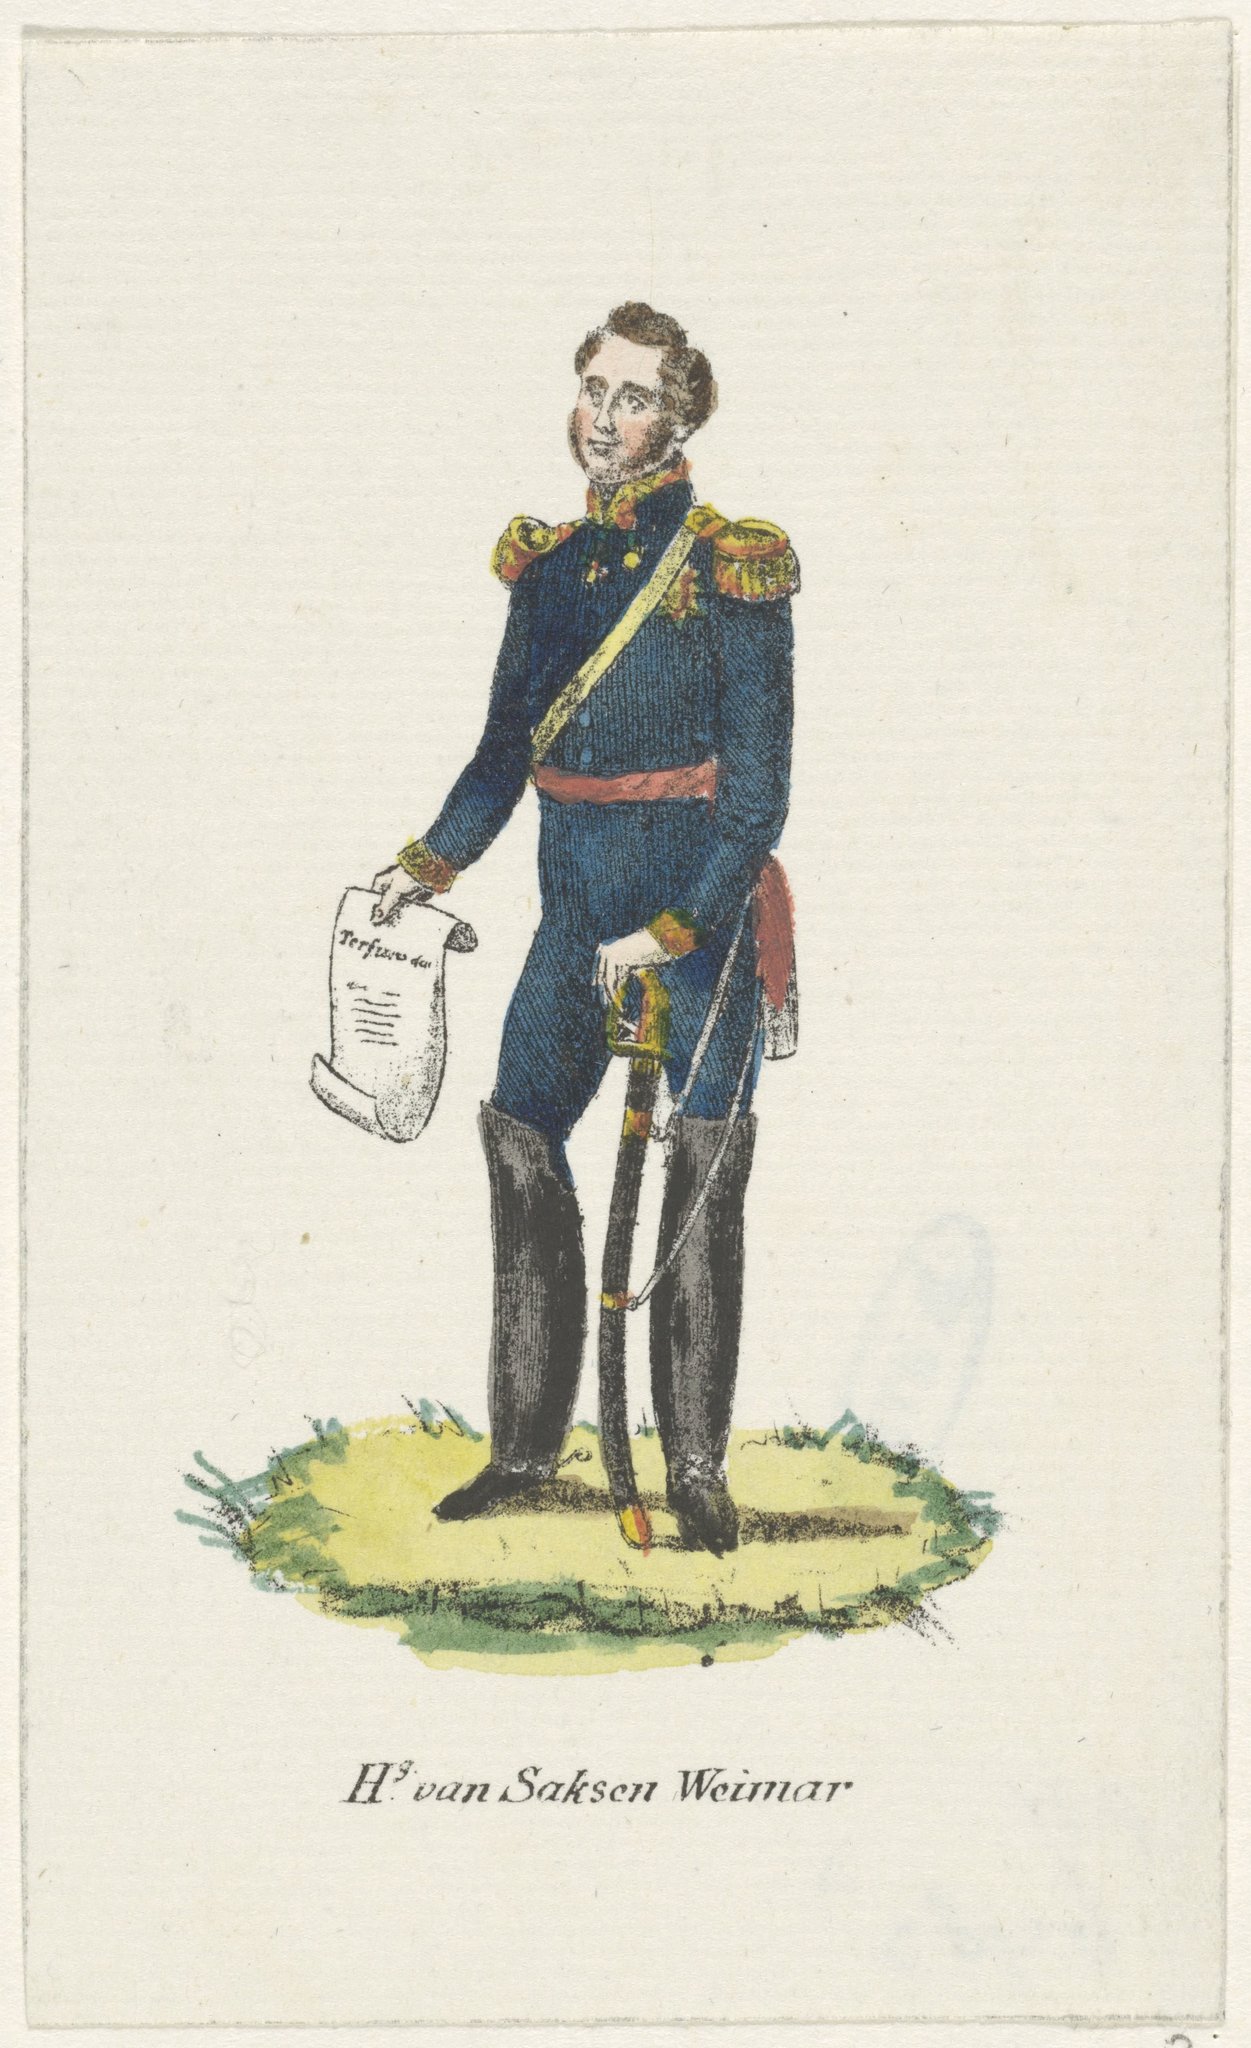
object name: costume print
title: 21 platen van Nederlandse uniformen ca. 1830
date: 1830-1835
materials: paper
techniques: hand coloring, lithograph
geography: netherlands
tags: karel bernhard (hertog van saksen-weimar-eisenach), (military) uniforms, clothes, costume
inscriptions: collector's mark: Lugt 2228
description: Verkleinde kopieën naar de prenten van Houtman e.a. in FMH 6481. Muller beschrijft een onversneden compleet blad in de collectie Van Gijn waarop de namen van de prentmaker en de uitgever vermeld staan.